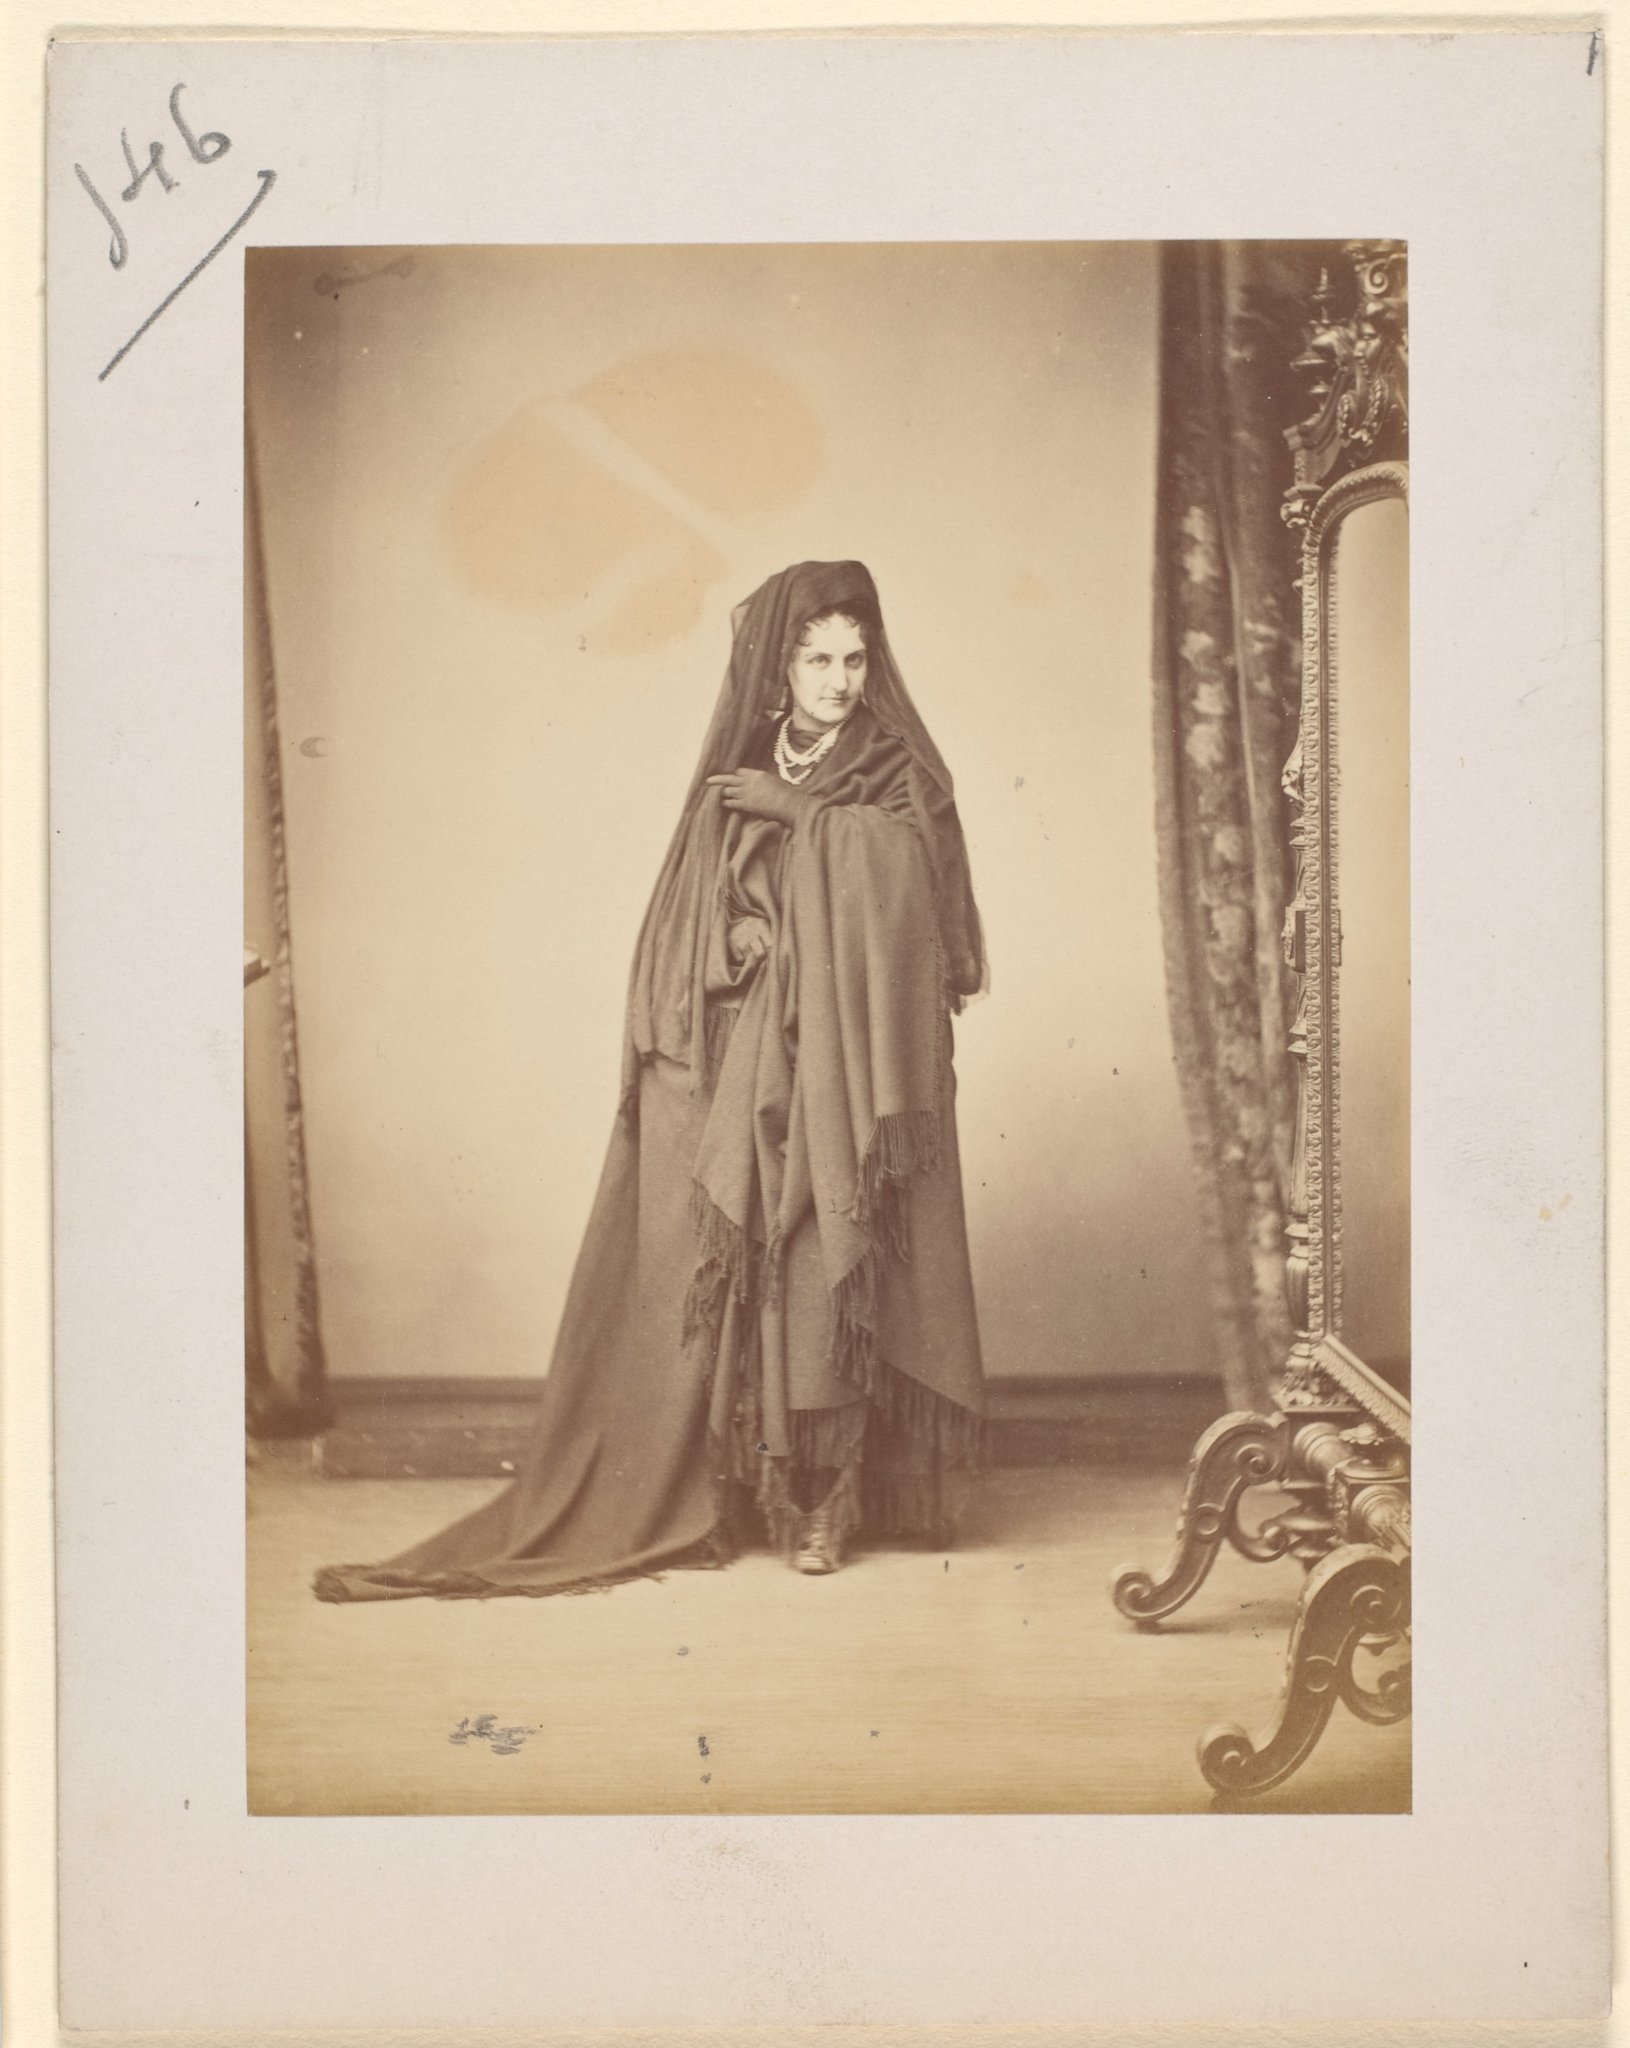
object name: photograph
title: Sèriè à la Ristori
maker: pierre-louis pierson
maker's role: artist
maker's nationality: french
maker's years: 1822-1913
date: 1860-1869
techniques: albumen silver print, glass negative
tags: portraits,women